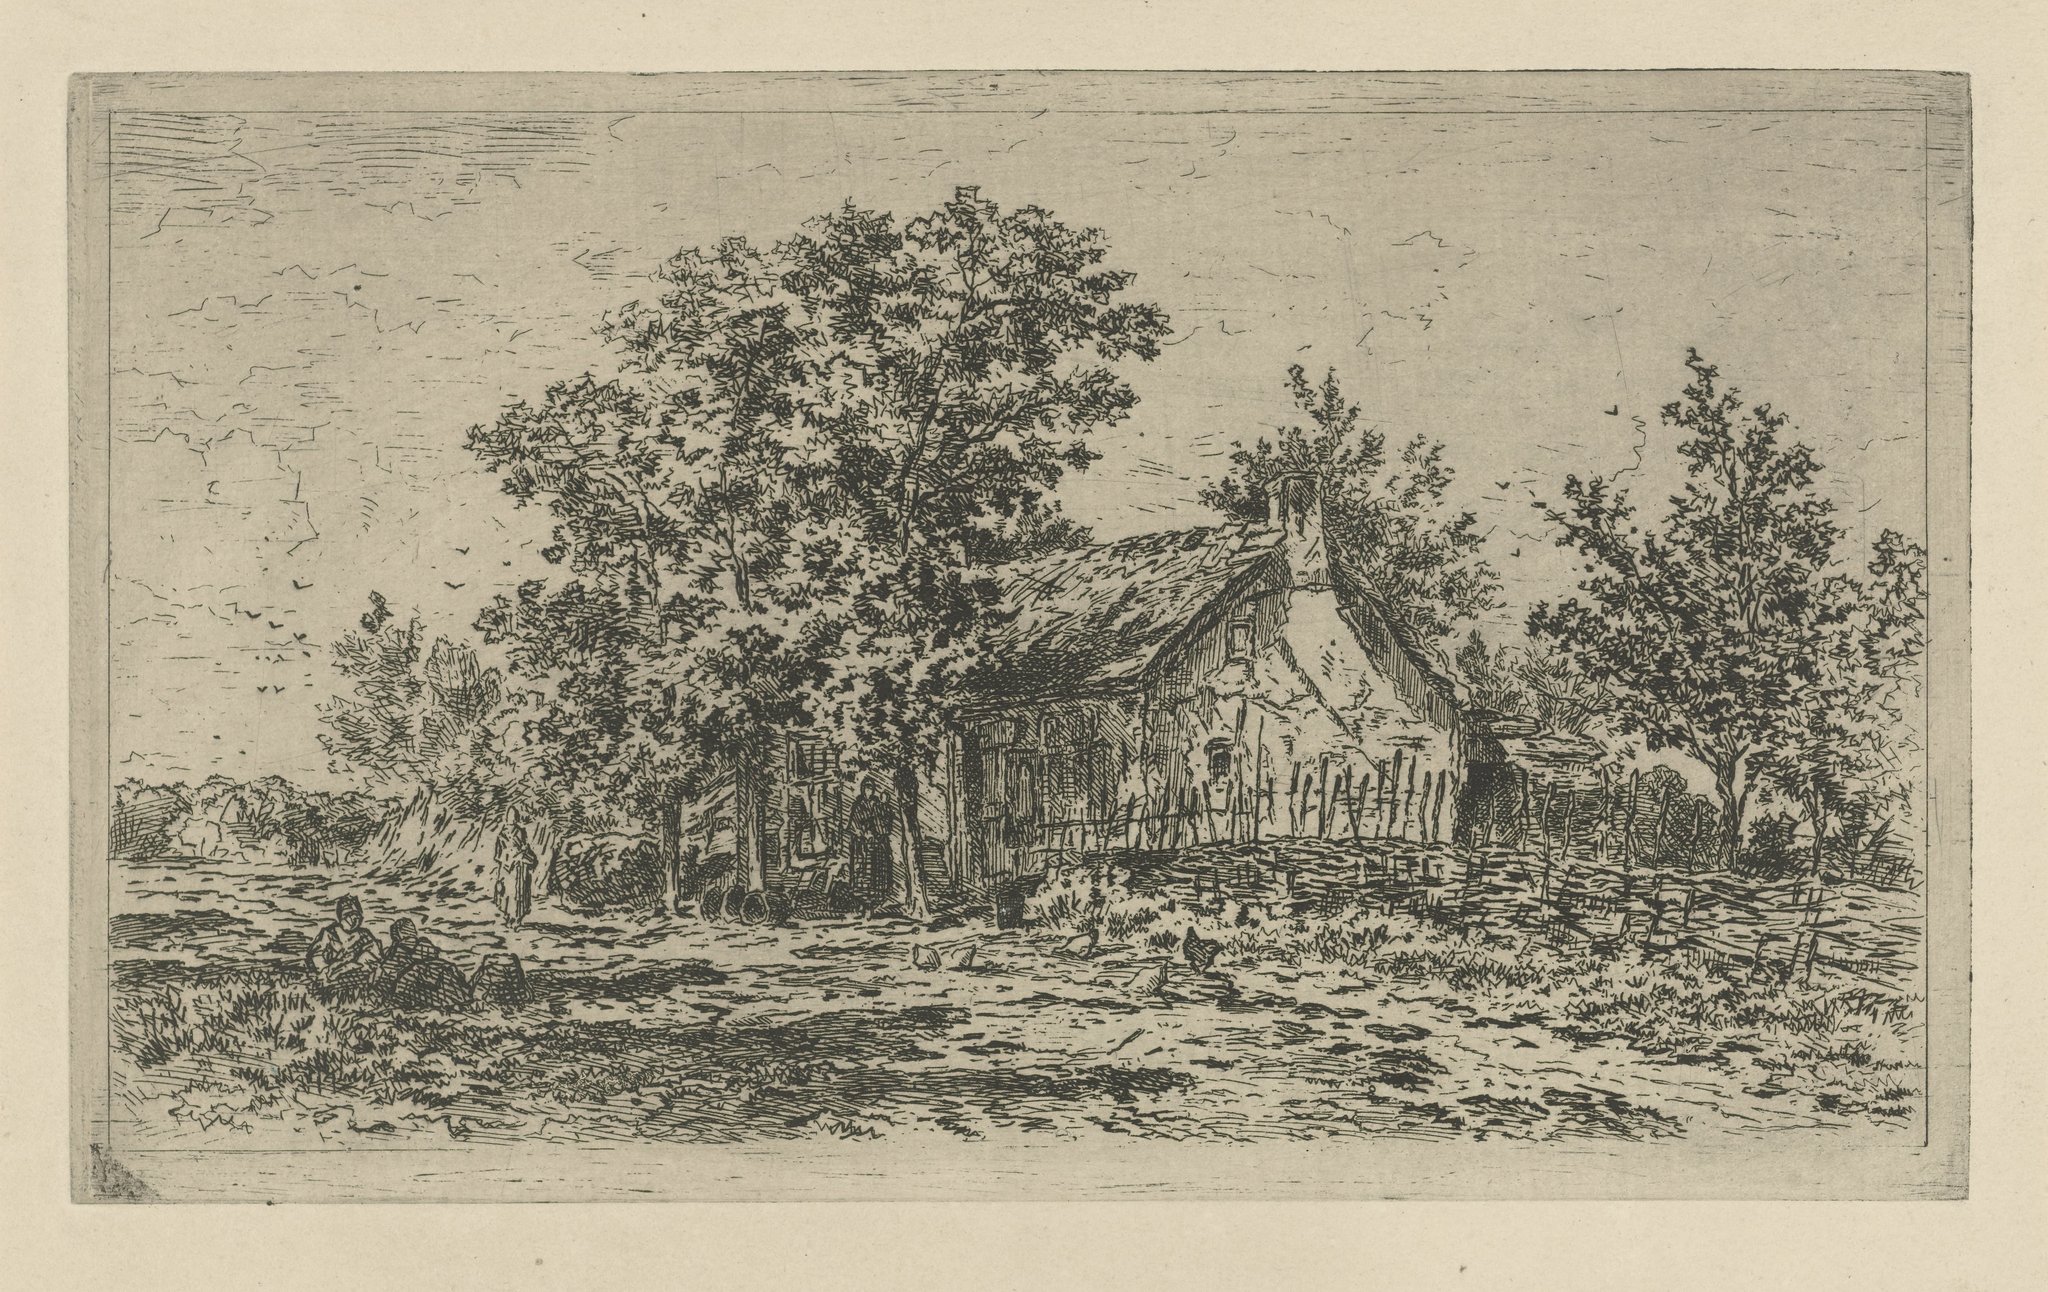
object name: print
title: Boerderij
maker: jan van lokhorst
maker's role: draughtsman, print maker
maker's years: 1837-1894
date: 1847-1874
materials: paper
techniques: etching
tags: farm or solitary house in landscape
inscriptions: collector's mark: Lugt 2228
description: Gezicht op een boerderij in een landschap. Links op de voorgrond zitten twee figuren in het gras.